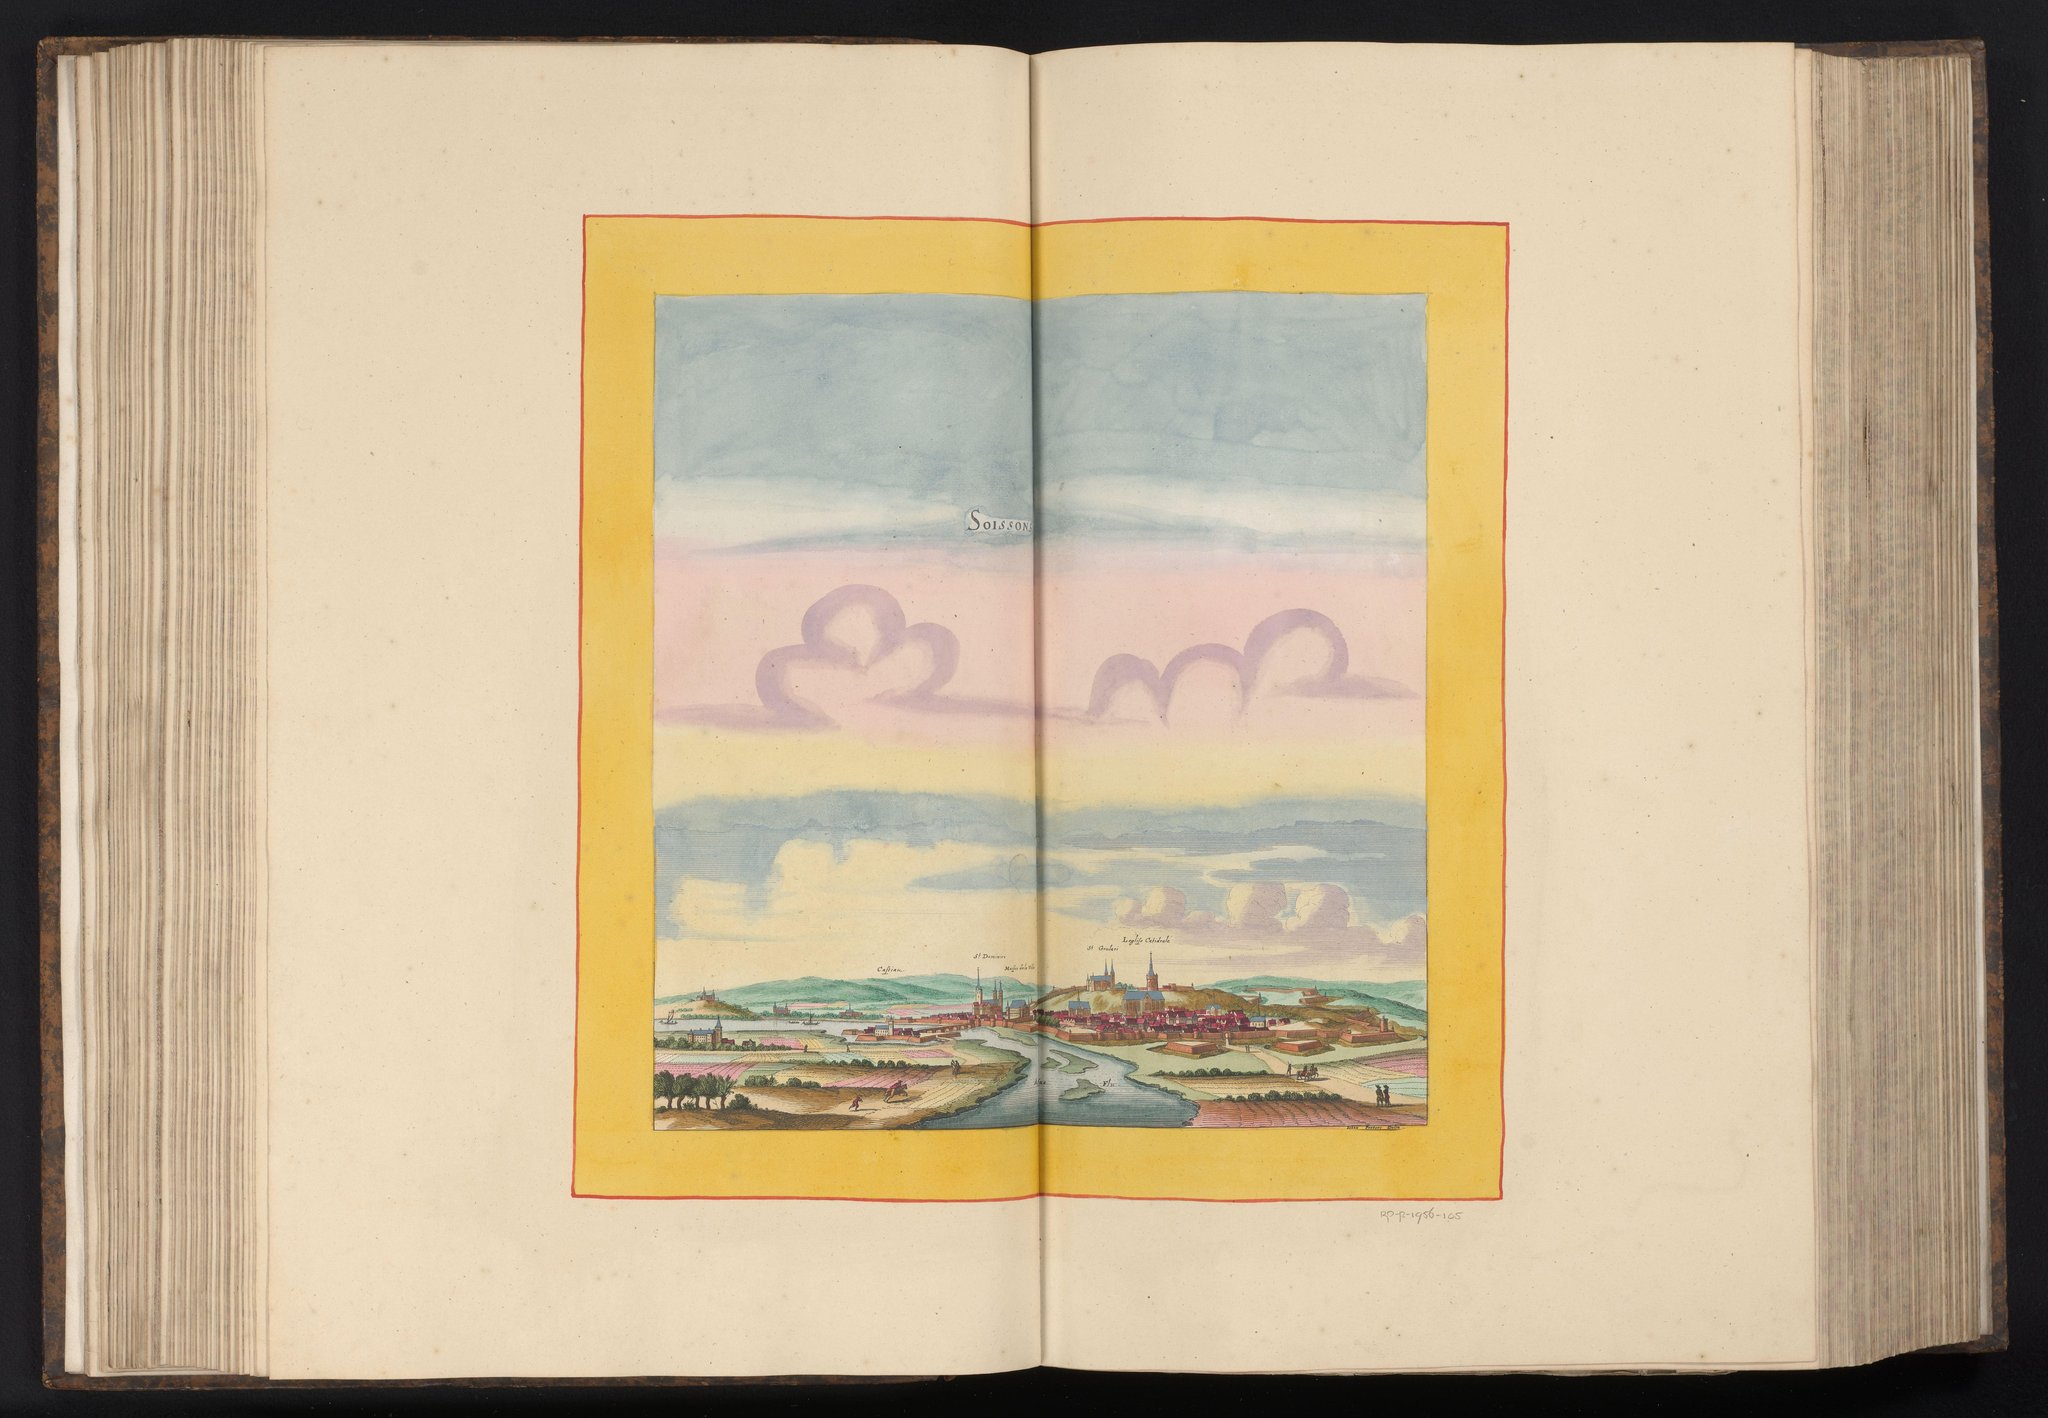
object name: album leaf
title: Gezicht op Soissons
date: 1656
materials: paper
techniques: engraving, etching, hand coloring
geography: the hague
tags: city-view in general; 'veduta'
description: Prent uit: Zeiller, Martin. Topographia Galliae. 13 dln. Frankfurt: Caspar Merian, 1656, dl. 2, na p. 34. De titel is uit de originele prent gesneden. Boven de gravure is een deel lucht en wolken (bij)geschilderd, waarin de titel gelijmd is.